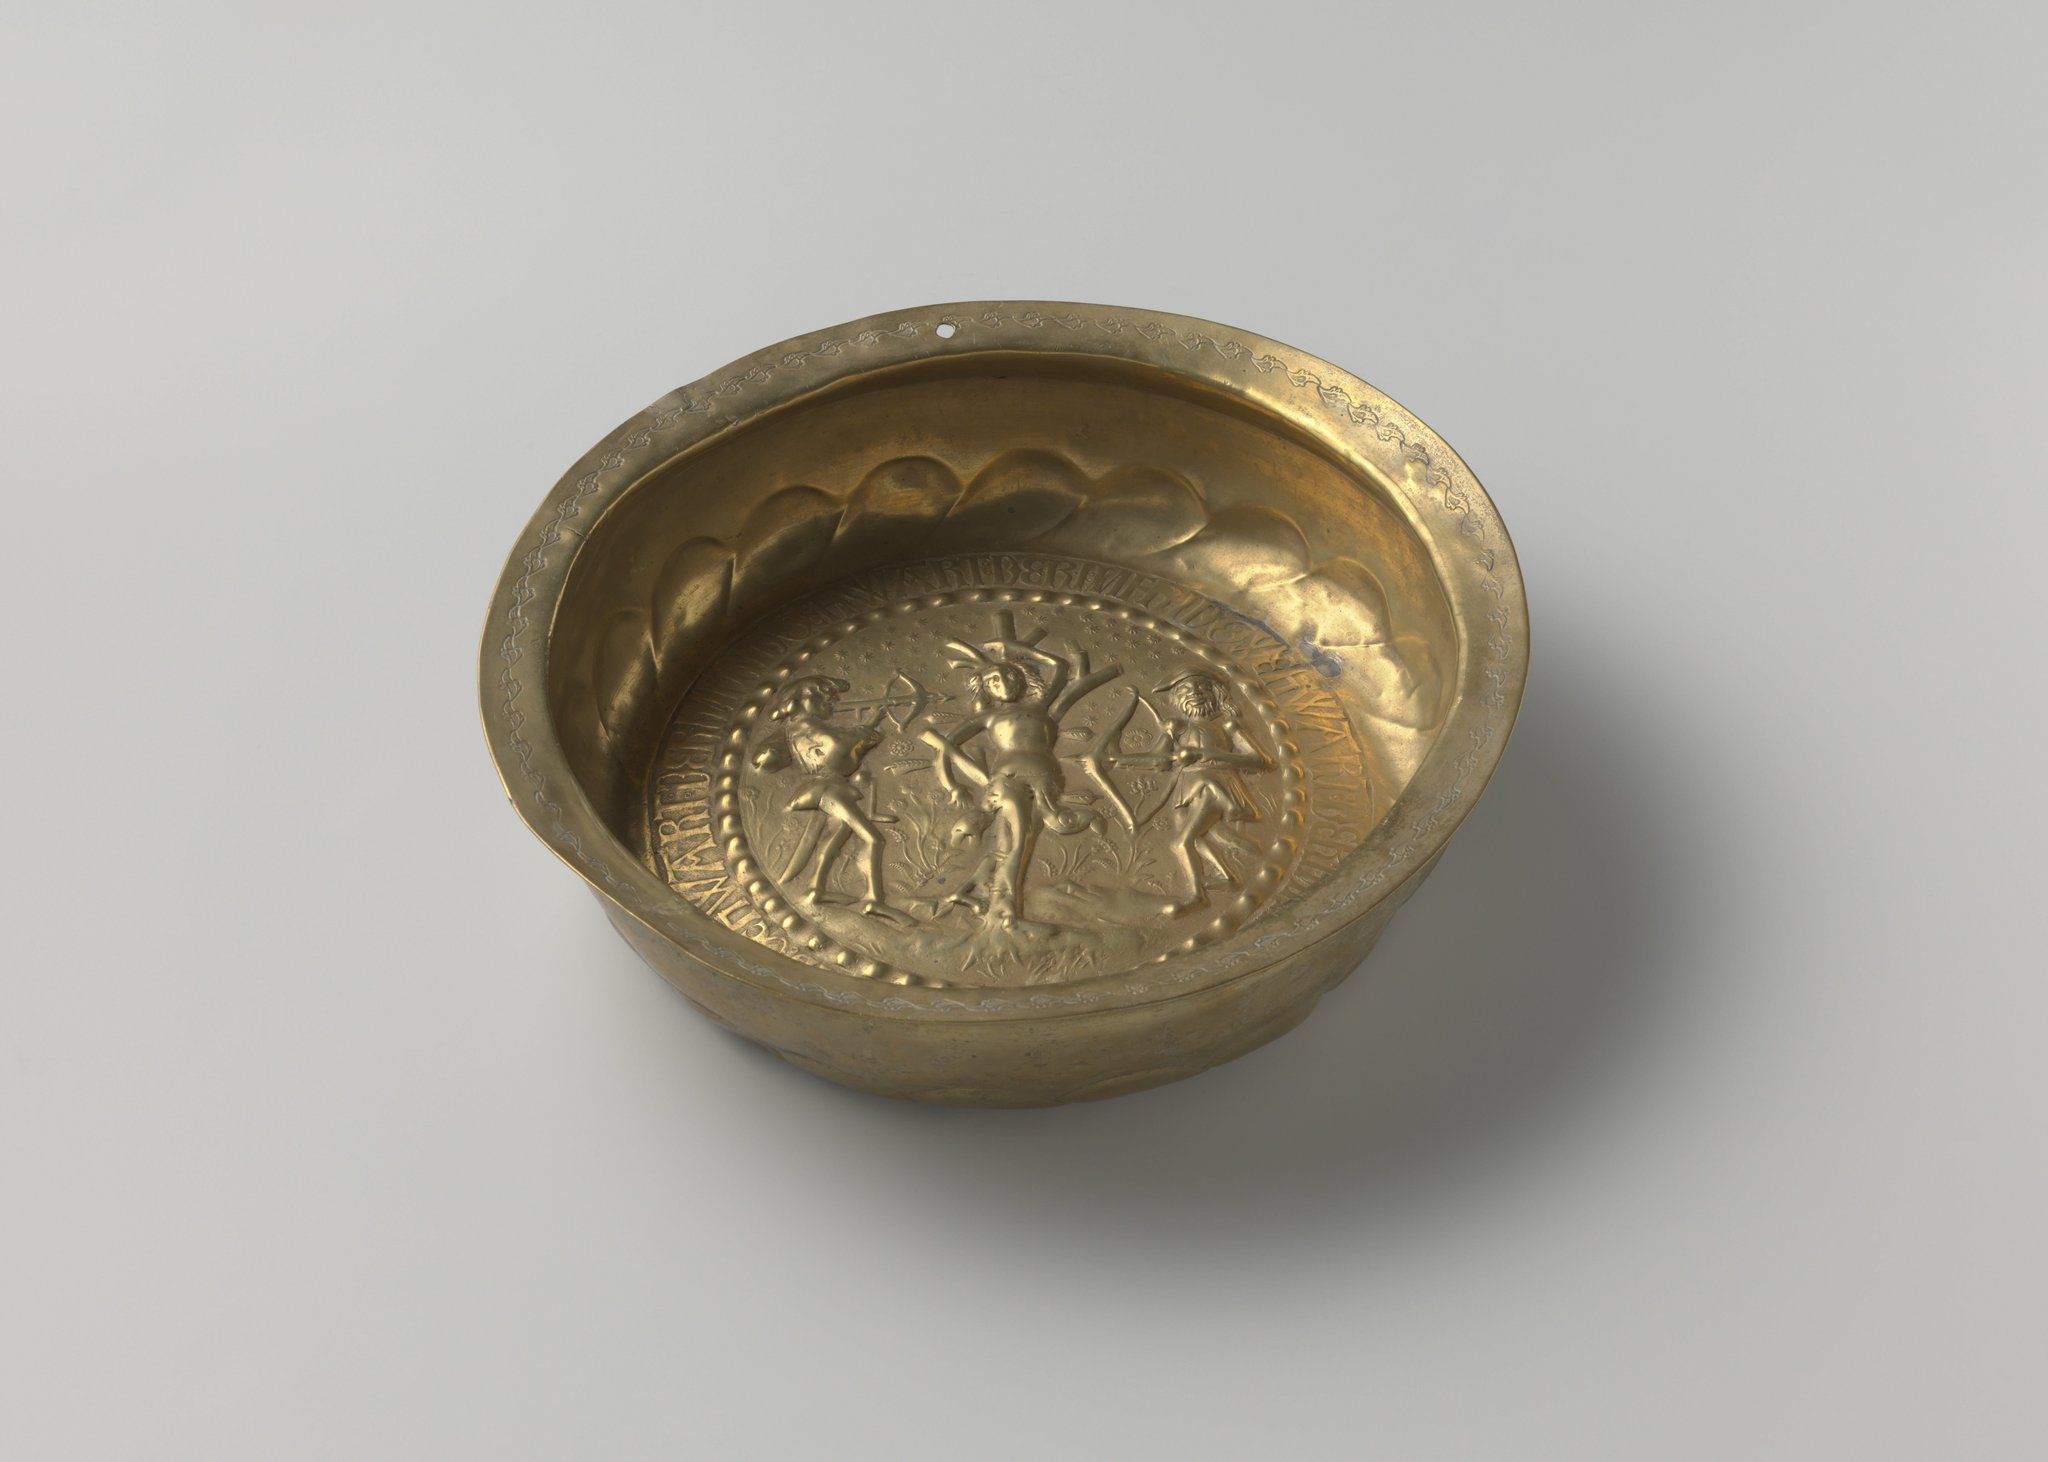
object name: bekken schaal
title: Bekken met de heilige Sebastiaan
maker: Anonymous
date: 1450-1550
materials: brass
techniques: casting, metalworking, engraving, punching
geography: nuremberg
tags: st. sebastian pierced by arrows, the archers visible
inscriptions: inscription: ‘DER IN FRID GWEHWAHRT (een maal)’, inscription: ‘DER IN FRID GEHWAHRT (drie maal)’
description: In het plat van het bekken, dat in het midden het centerpunt heeft, zijn met behulp van stempelvormen geponst: een voorstelling van de H. Sebastiaan en twee boogschutters, alsmede het op gearceerde achtergrond aangebracht opschrift DER IN FRID GEHWAHRT (vier maal herhaald). Op de voorstelling is in het midden de aan een boom vastgebonden H. Sebastiaan weergegeven en links en rechts een boogschutter. De achtergrond wordt ingenomen door bloeiende planten en een sterrenhemel. In de wand van de schotel zijn visblazen gedreven. In de kraag is een geponst ornament aangebracht met als motief een gestileerd blad. De hangring aan de achterzijde en het gat in de rand zijn later aangebracht.